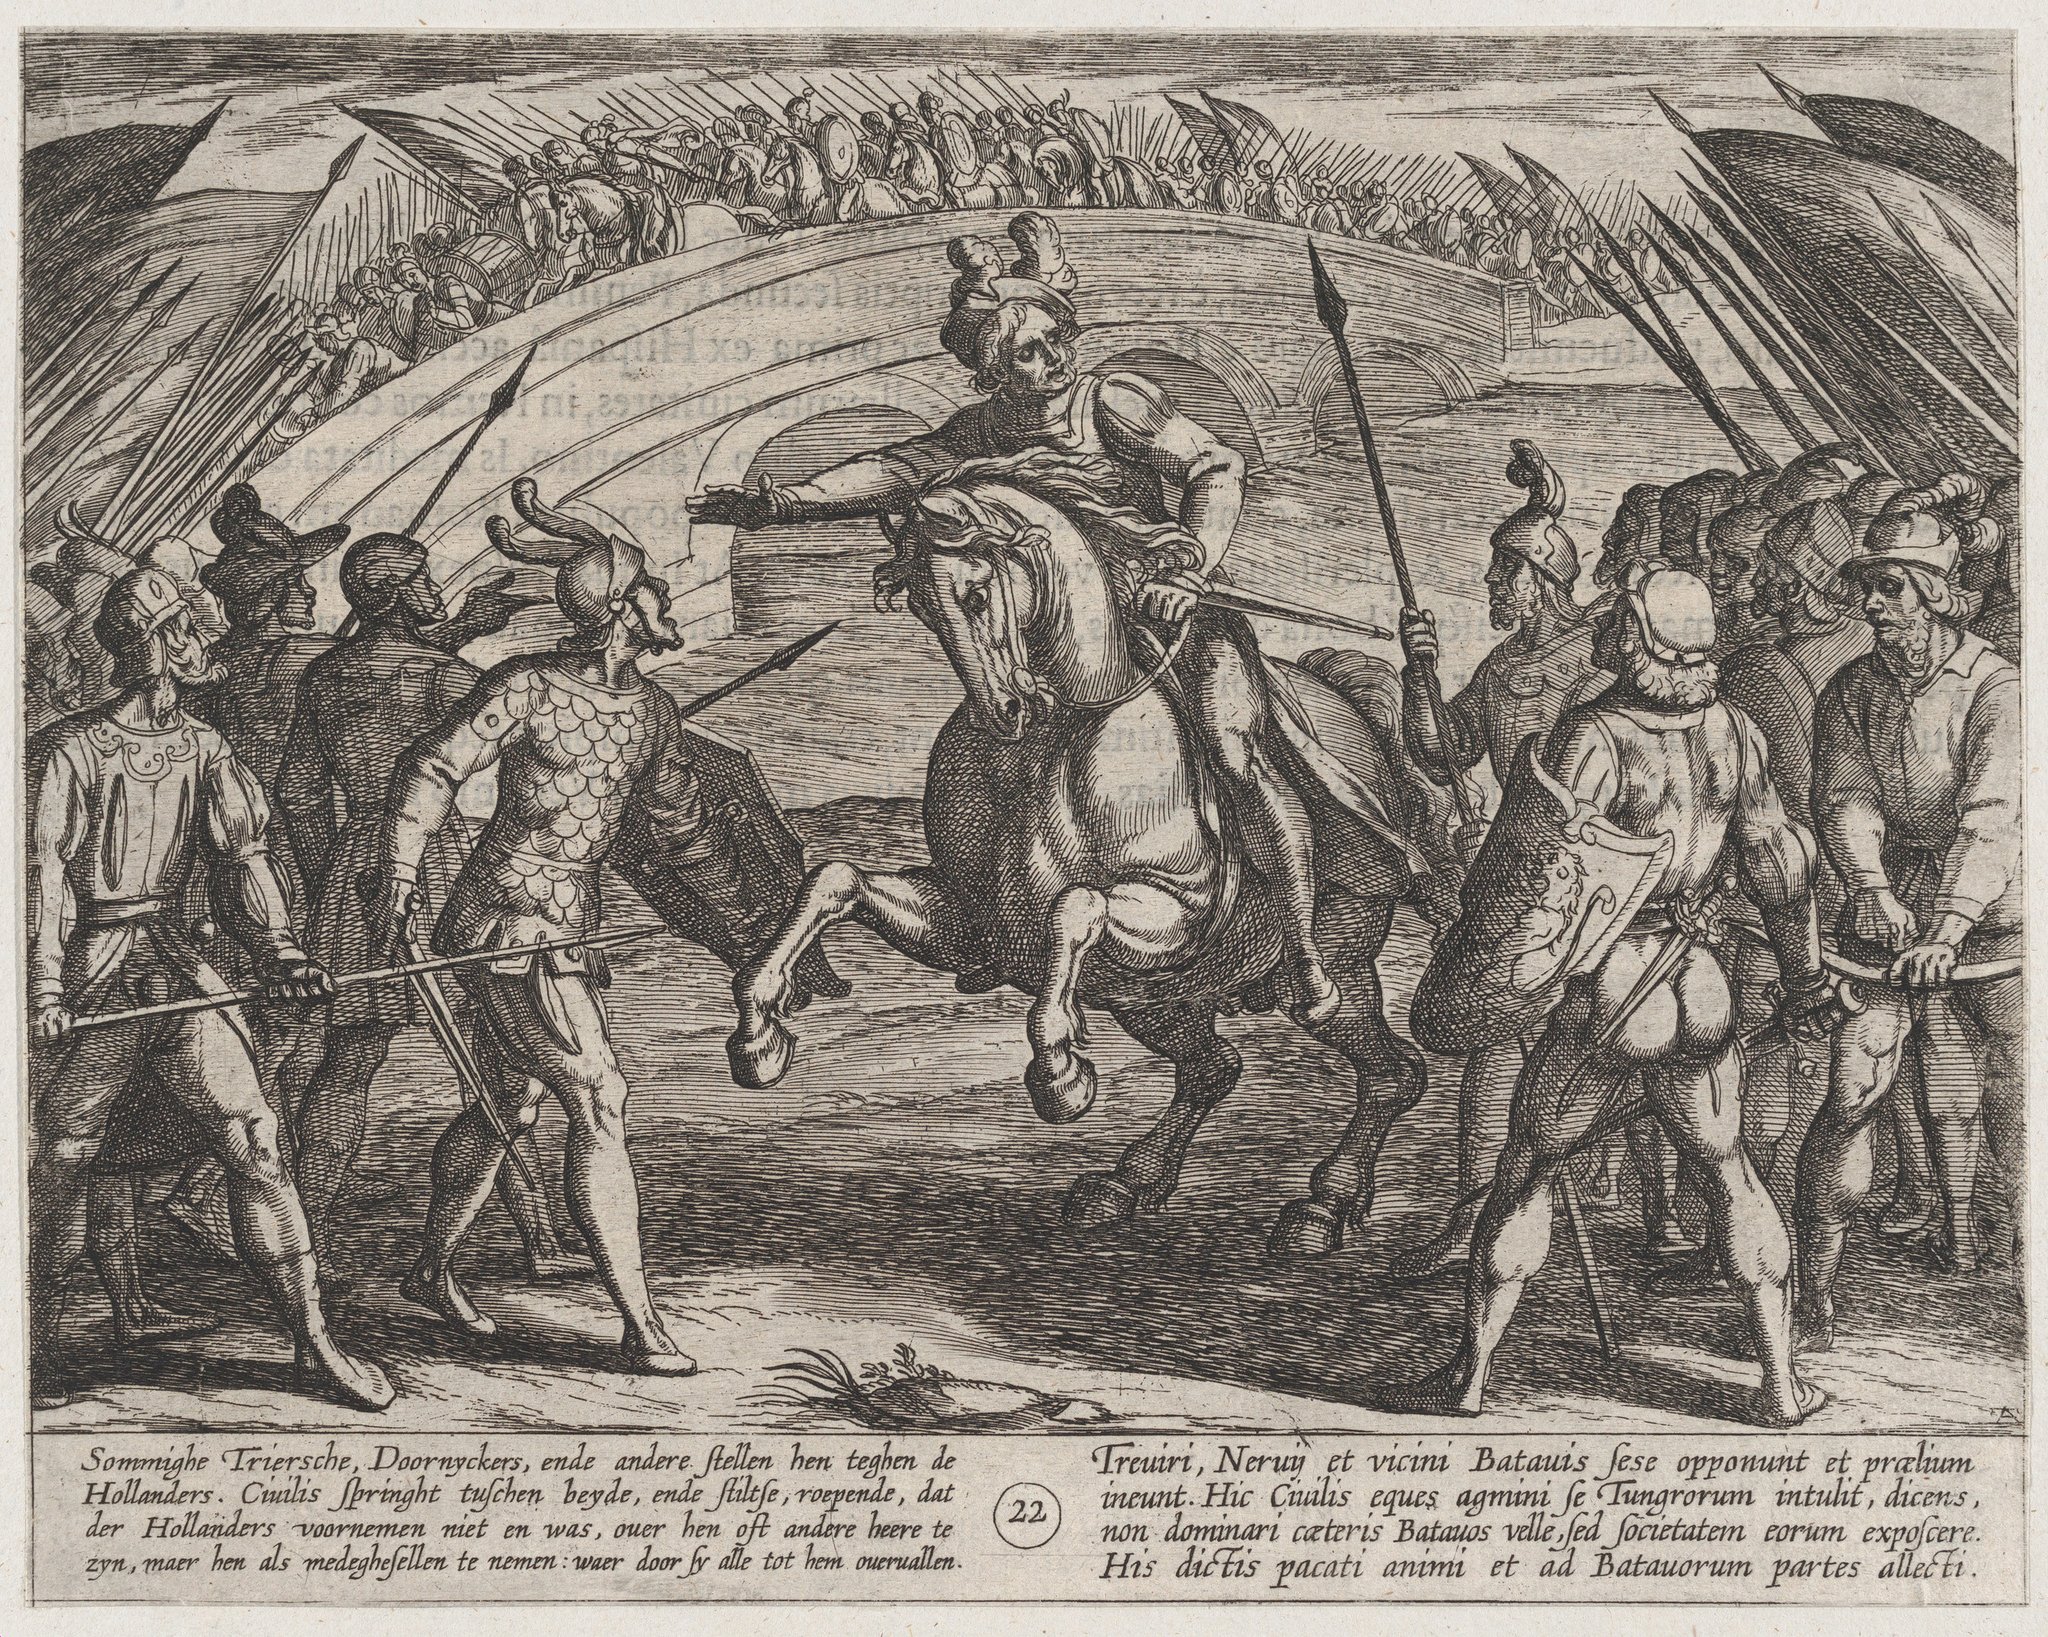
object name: print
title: Plate 22: Civilis Separates German and Dutch Troops, from The War of the Romans Against the Batavians (Romanorvm et Batavorvm societas)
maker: antonio tempesta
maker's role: artist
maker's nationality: italian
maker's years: 1555-1630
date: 1611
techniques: etching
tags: battles,soldiers,swords,horses